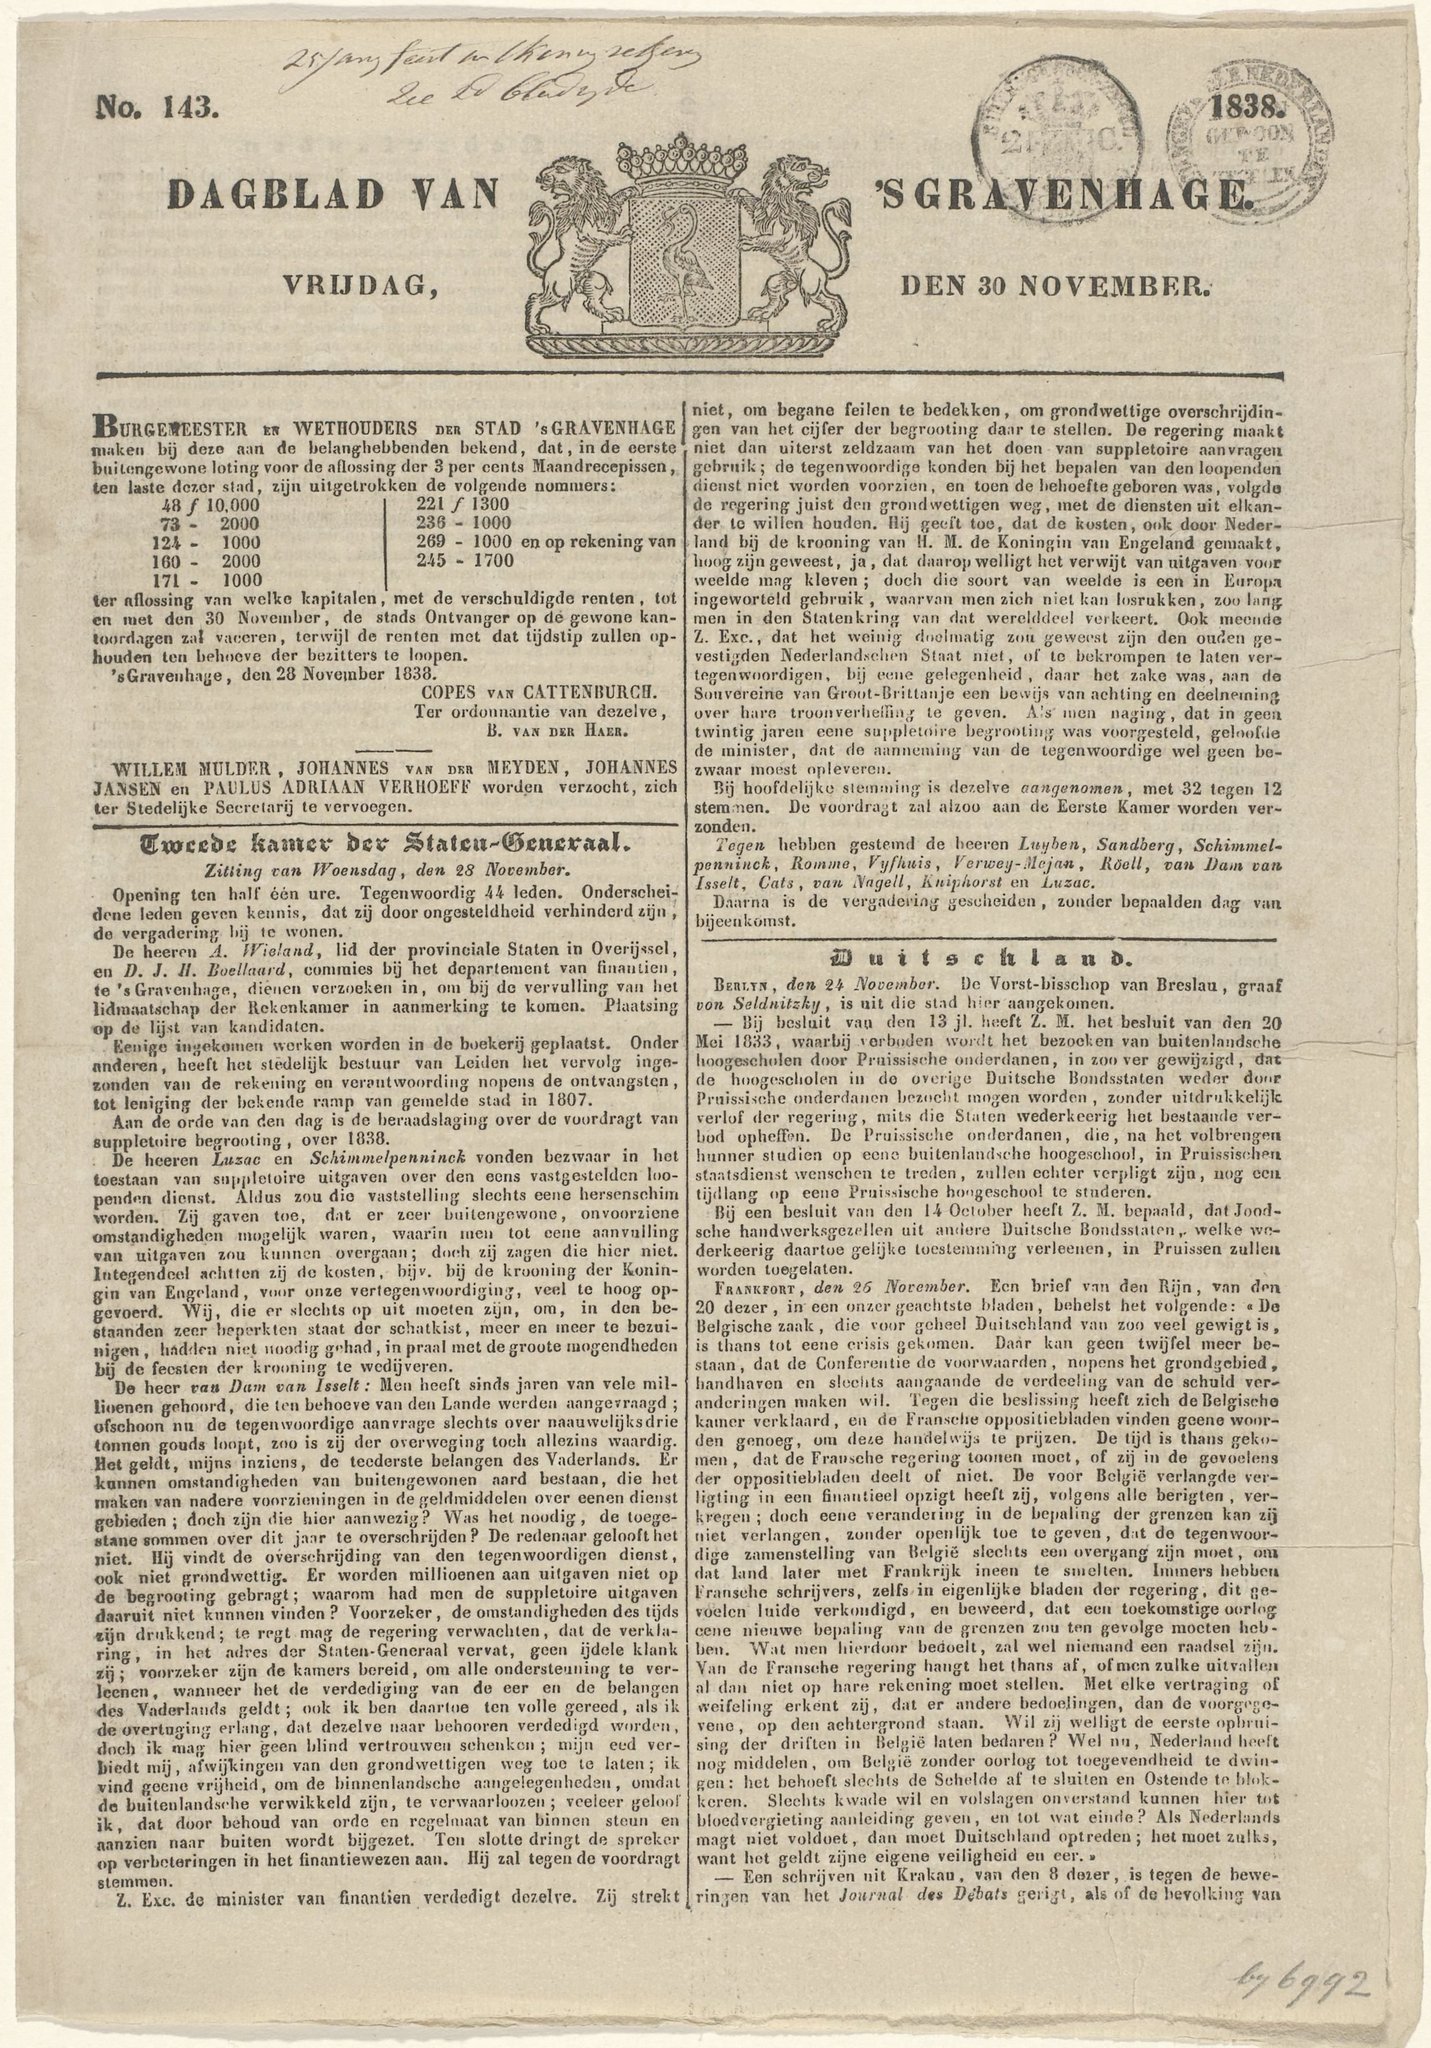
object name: newspaper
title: Dagblad van 's Gravenhage. Vrijdag, den 30 November. No. 143. 1838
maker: p.e. van staden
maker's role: printer, publisher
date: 1838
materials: paper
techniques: letterpress printing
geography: the hague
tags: berlin, william i of the netherlands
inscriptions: collector's mark: Lugt 2228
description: Exemplaar het 'Dagblad van 's Gravenhage' van 30 november 1838, met berichten over de viering van het vijfentwintigjarige regeringsjubileum van koning Willem I in november 1838. Dubbelgevouwen blad bedrukt op alle zijden.